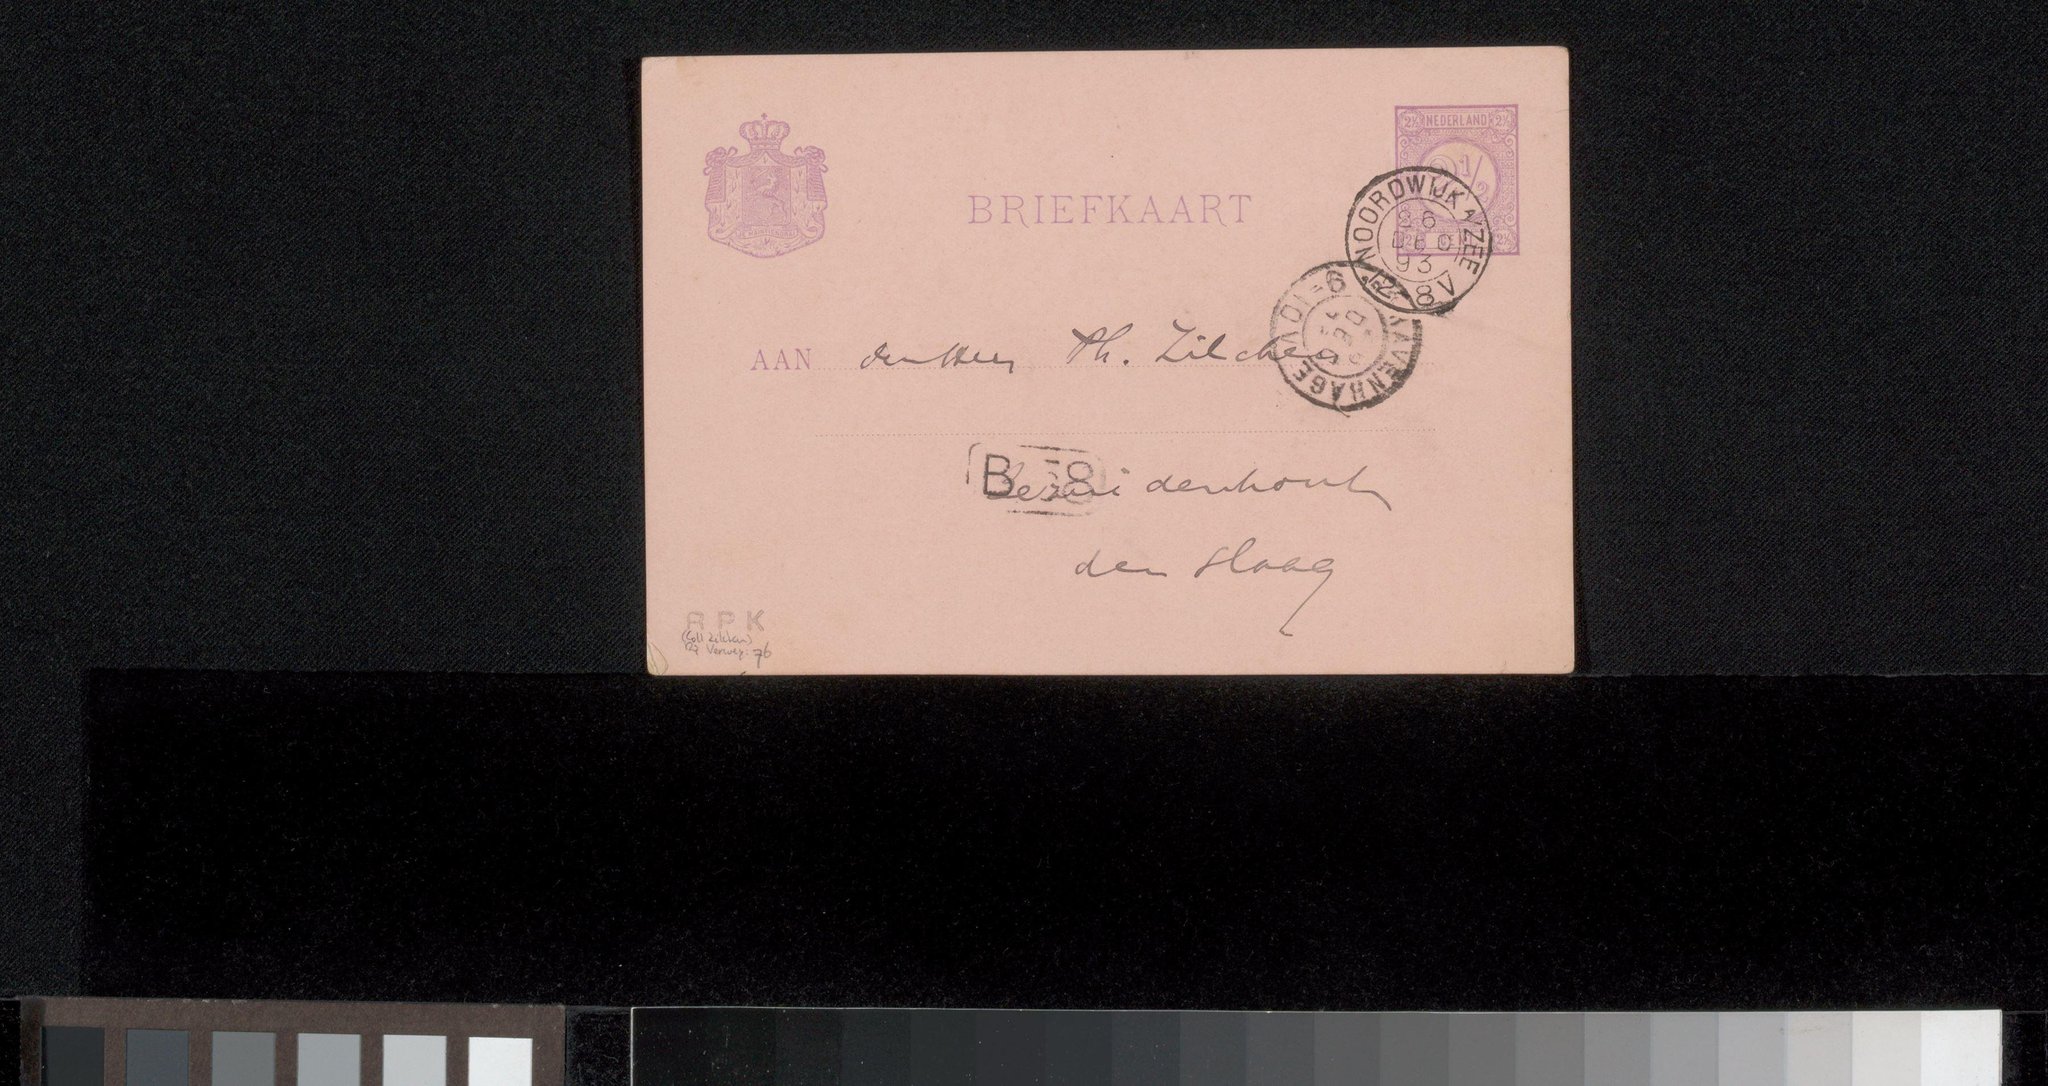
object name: postcard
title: Briefkaart aan Philip Zilcken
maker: albert verwey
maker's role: criticus, dichter, essayist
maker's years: 1865-1937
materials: cardboard, ink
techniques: pen, writing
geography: noordwijk aan zee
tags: arnhem, sculptor, saar de swart, richard nicolaüs roland holst, the hague, draughtsman, philip zilcken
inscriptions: collector's mark: ‘RPK’